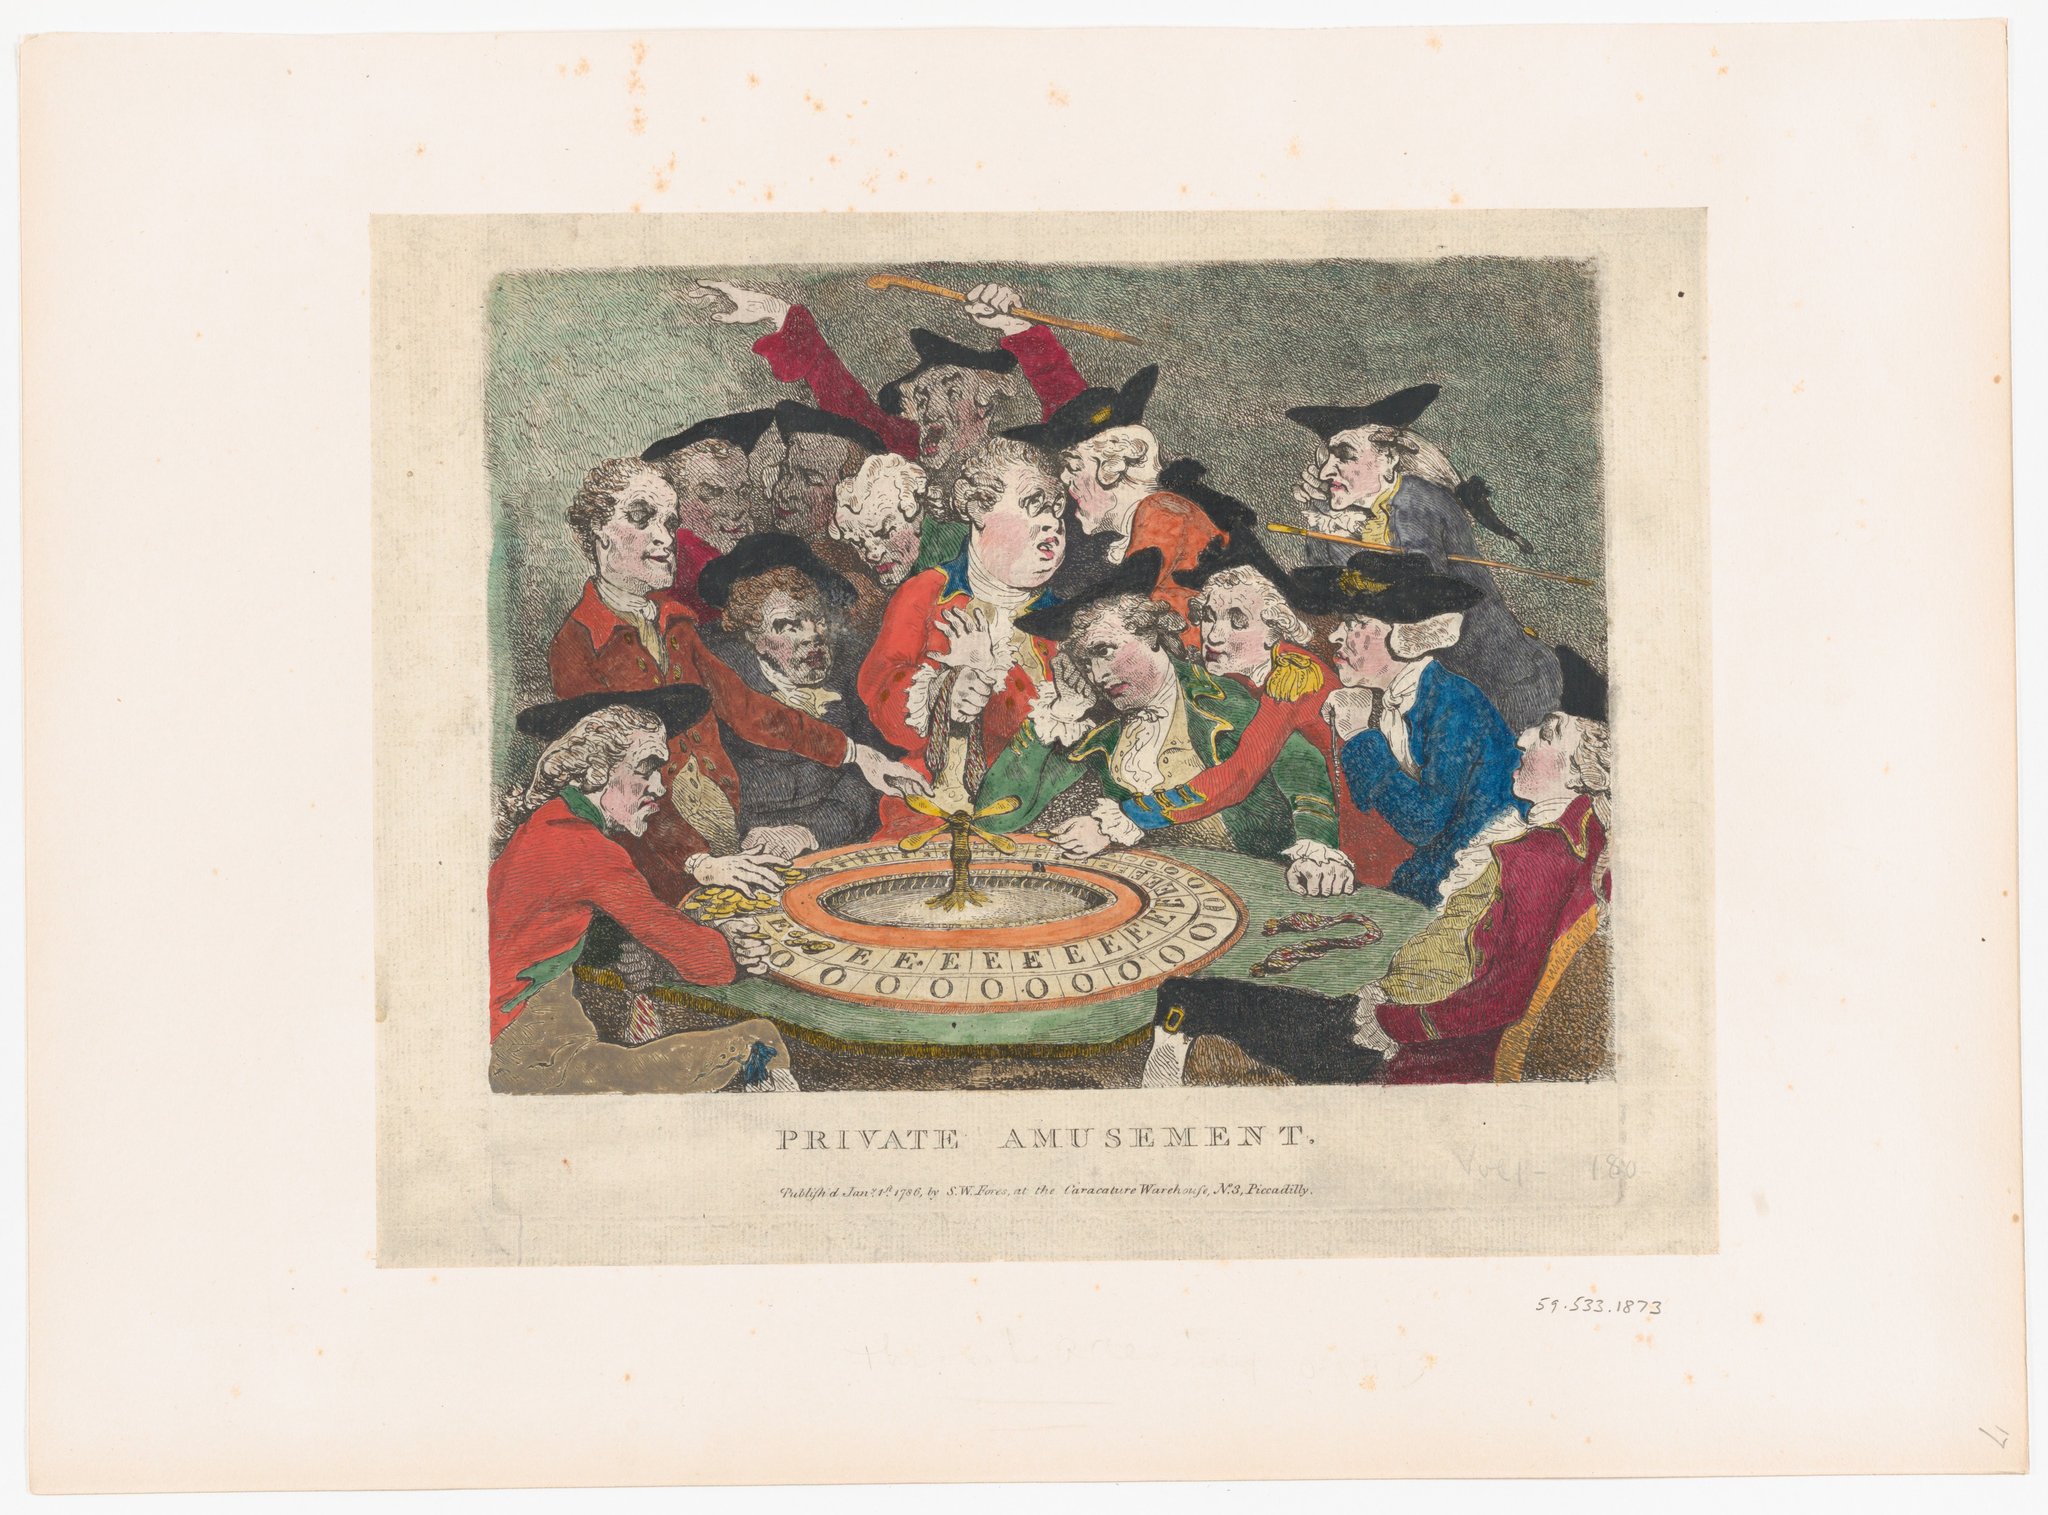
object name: print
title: Private Amusement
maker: thomas rowlandson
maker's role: artist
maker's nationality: british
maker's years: 1757-1827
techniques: etching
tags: satire,men,gambling